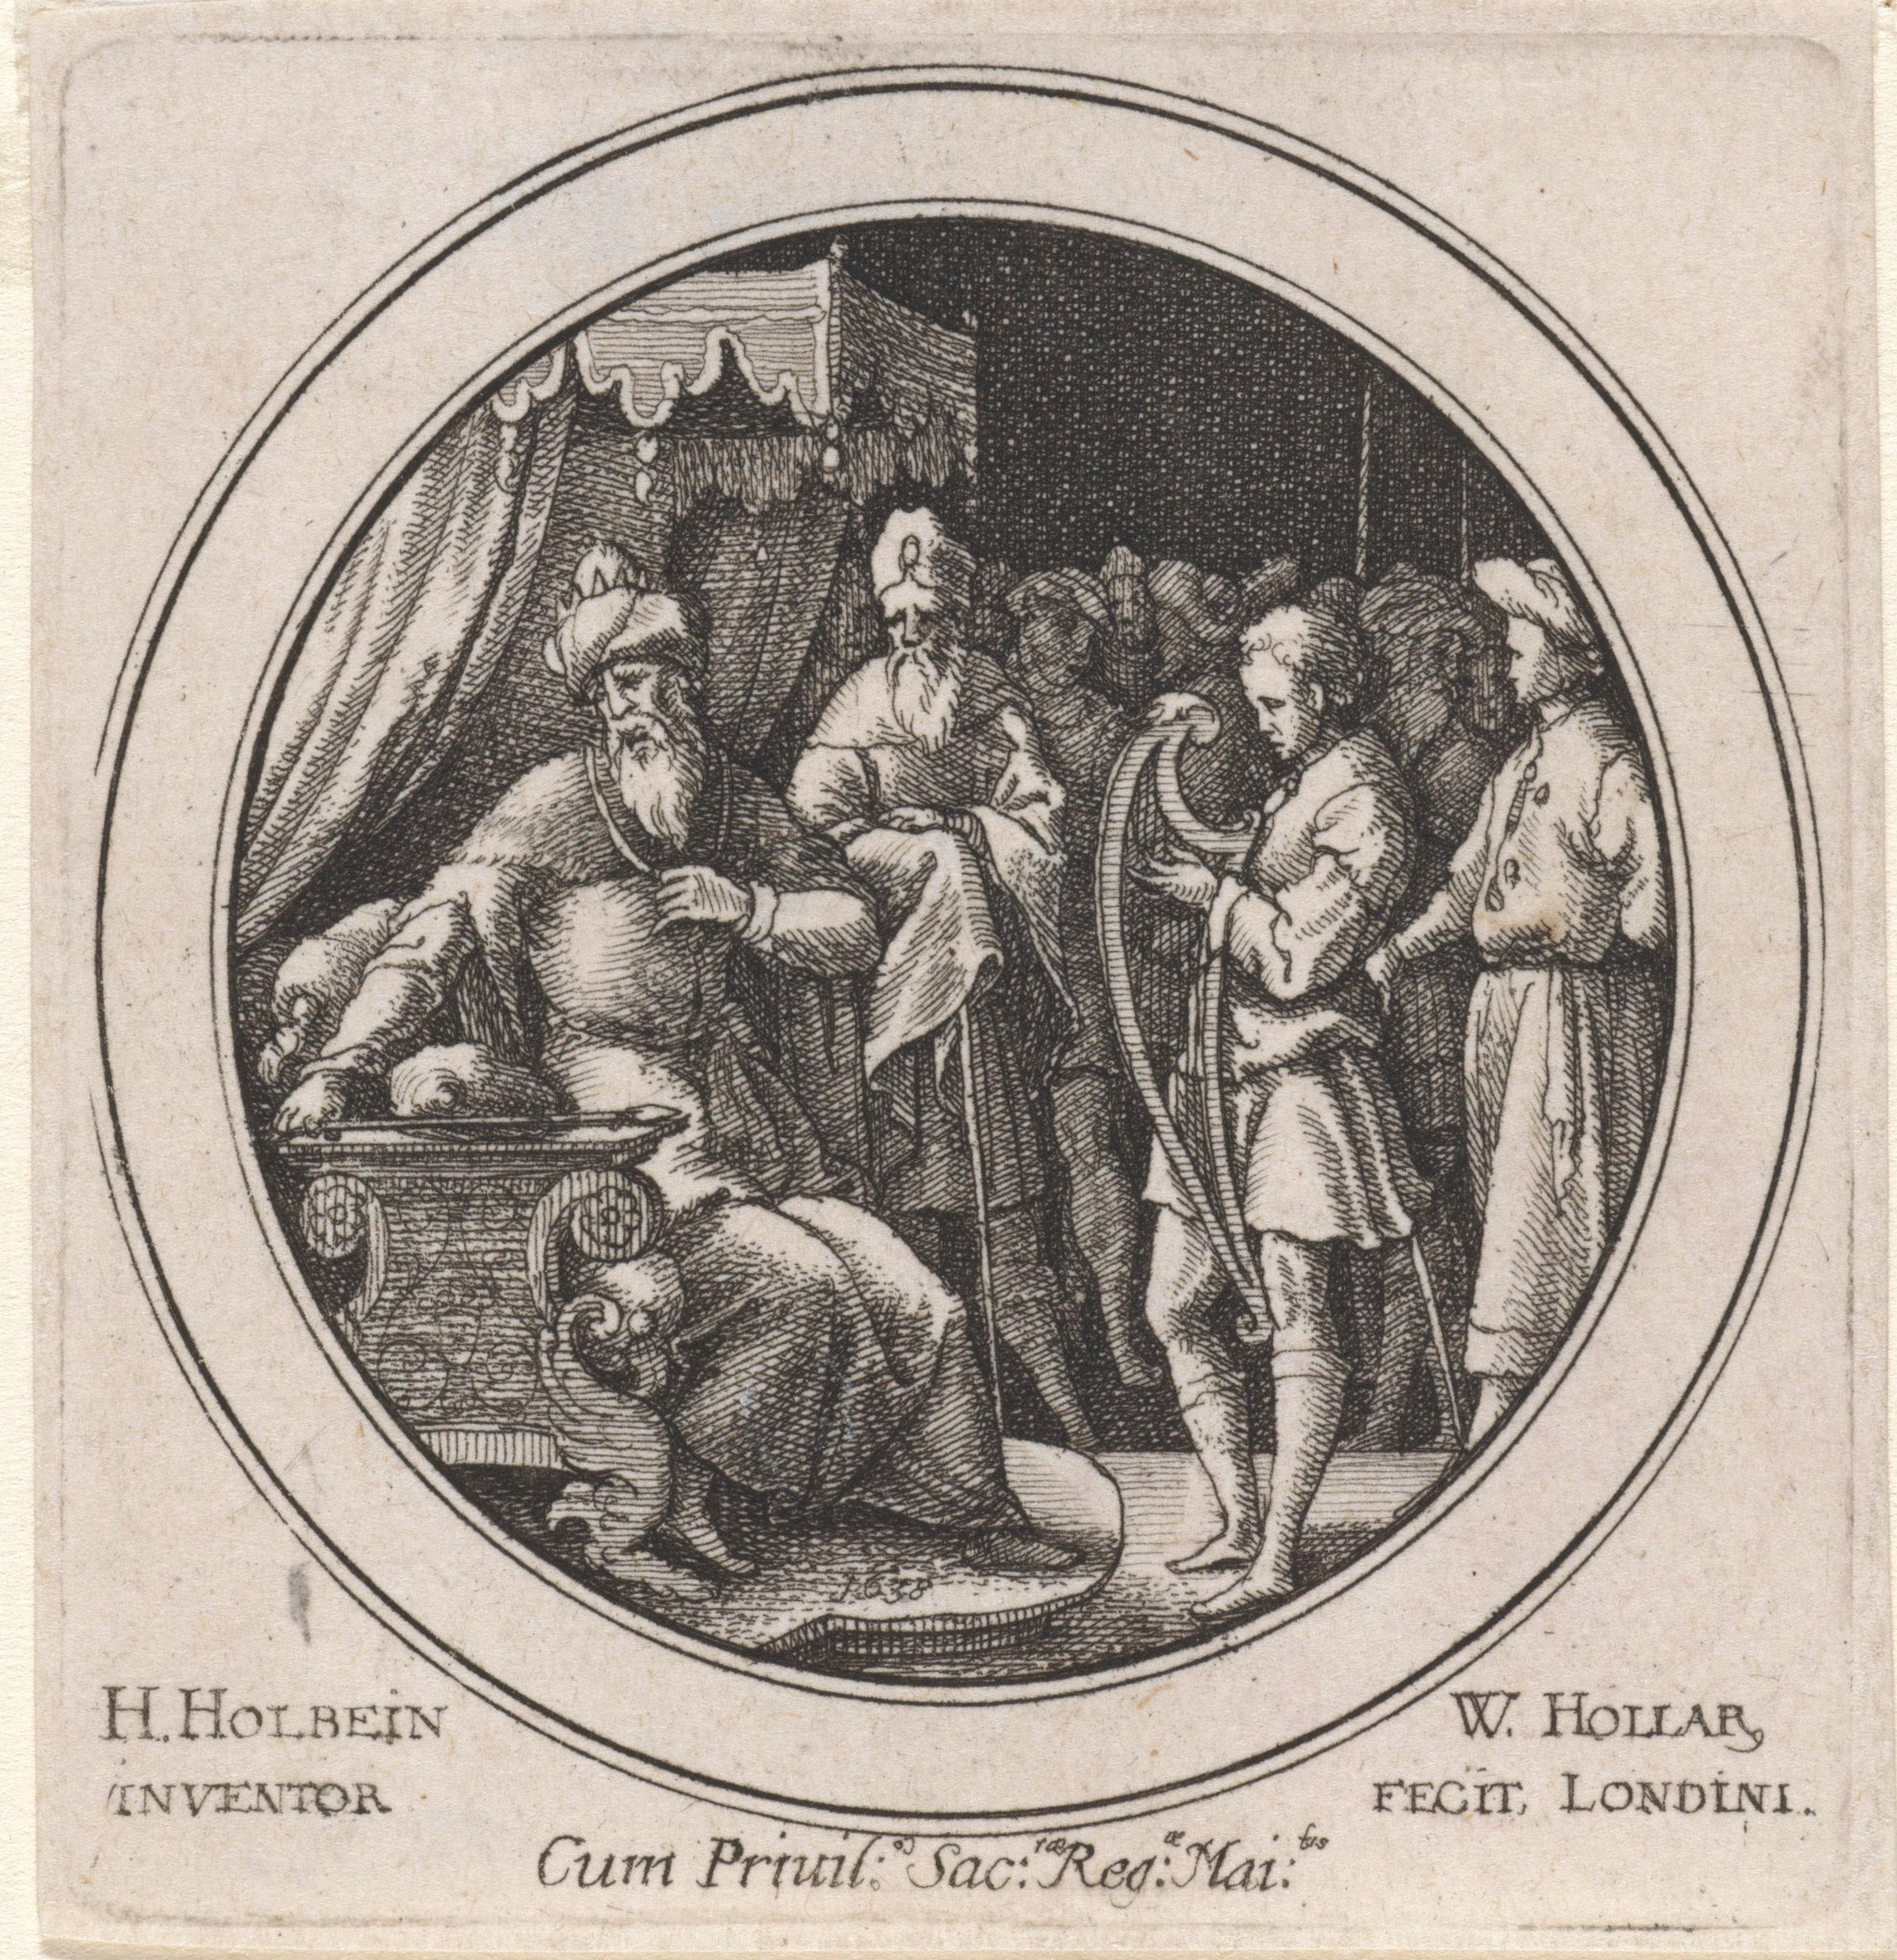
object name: print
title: David speelt harp voor Saul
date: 1638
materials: paper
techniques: etching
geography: london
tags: david playing his harp before saul, harp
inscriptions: collector's mark: Lugt 240